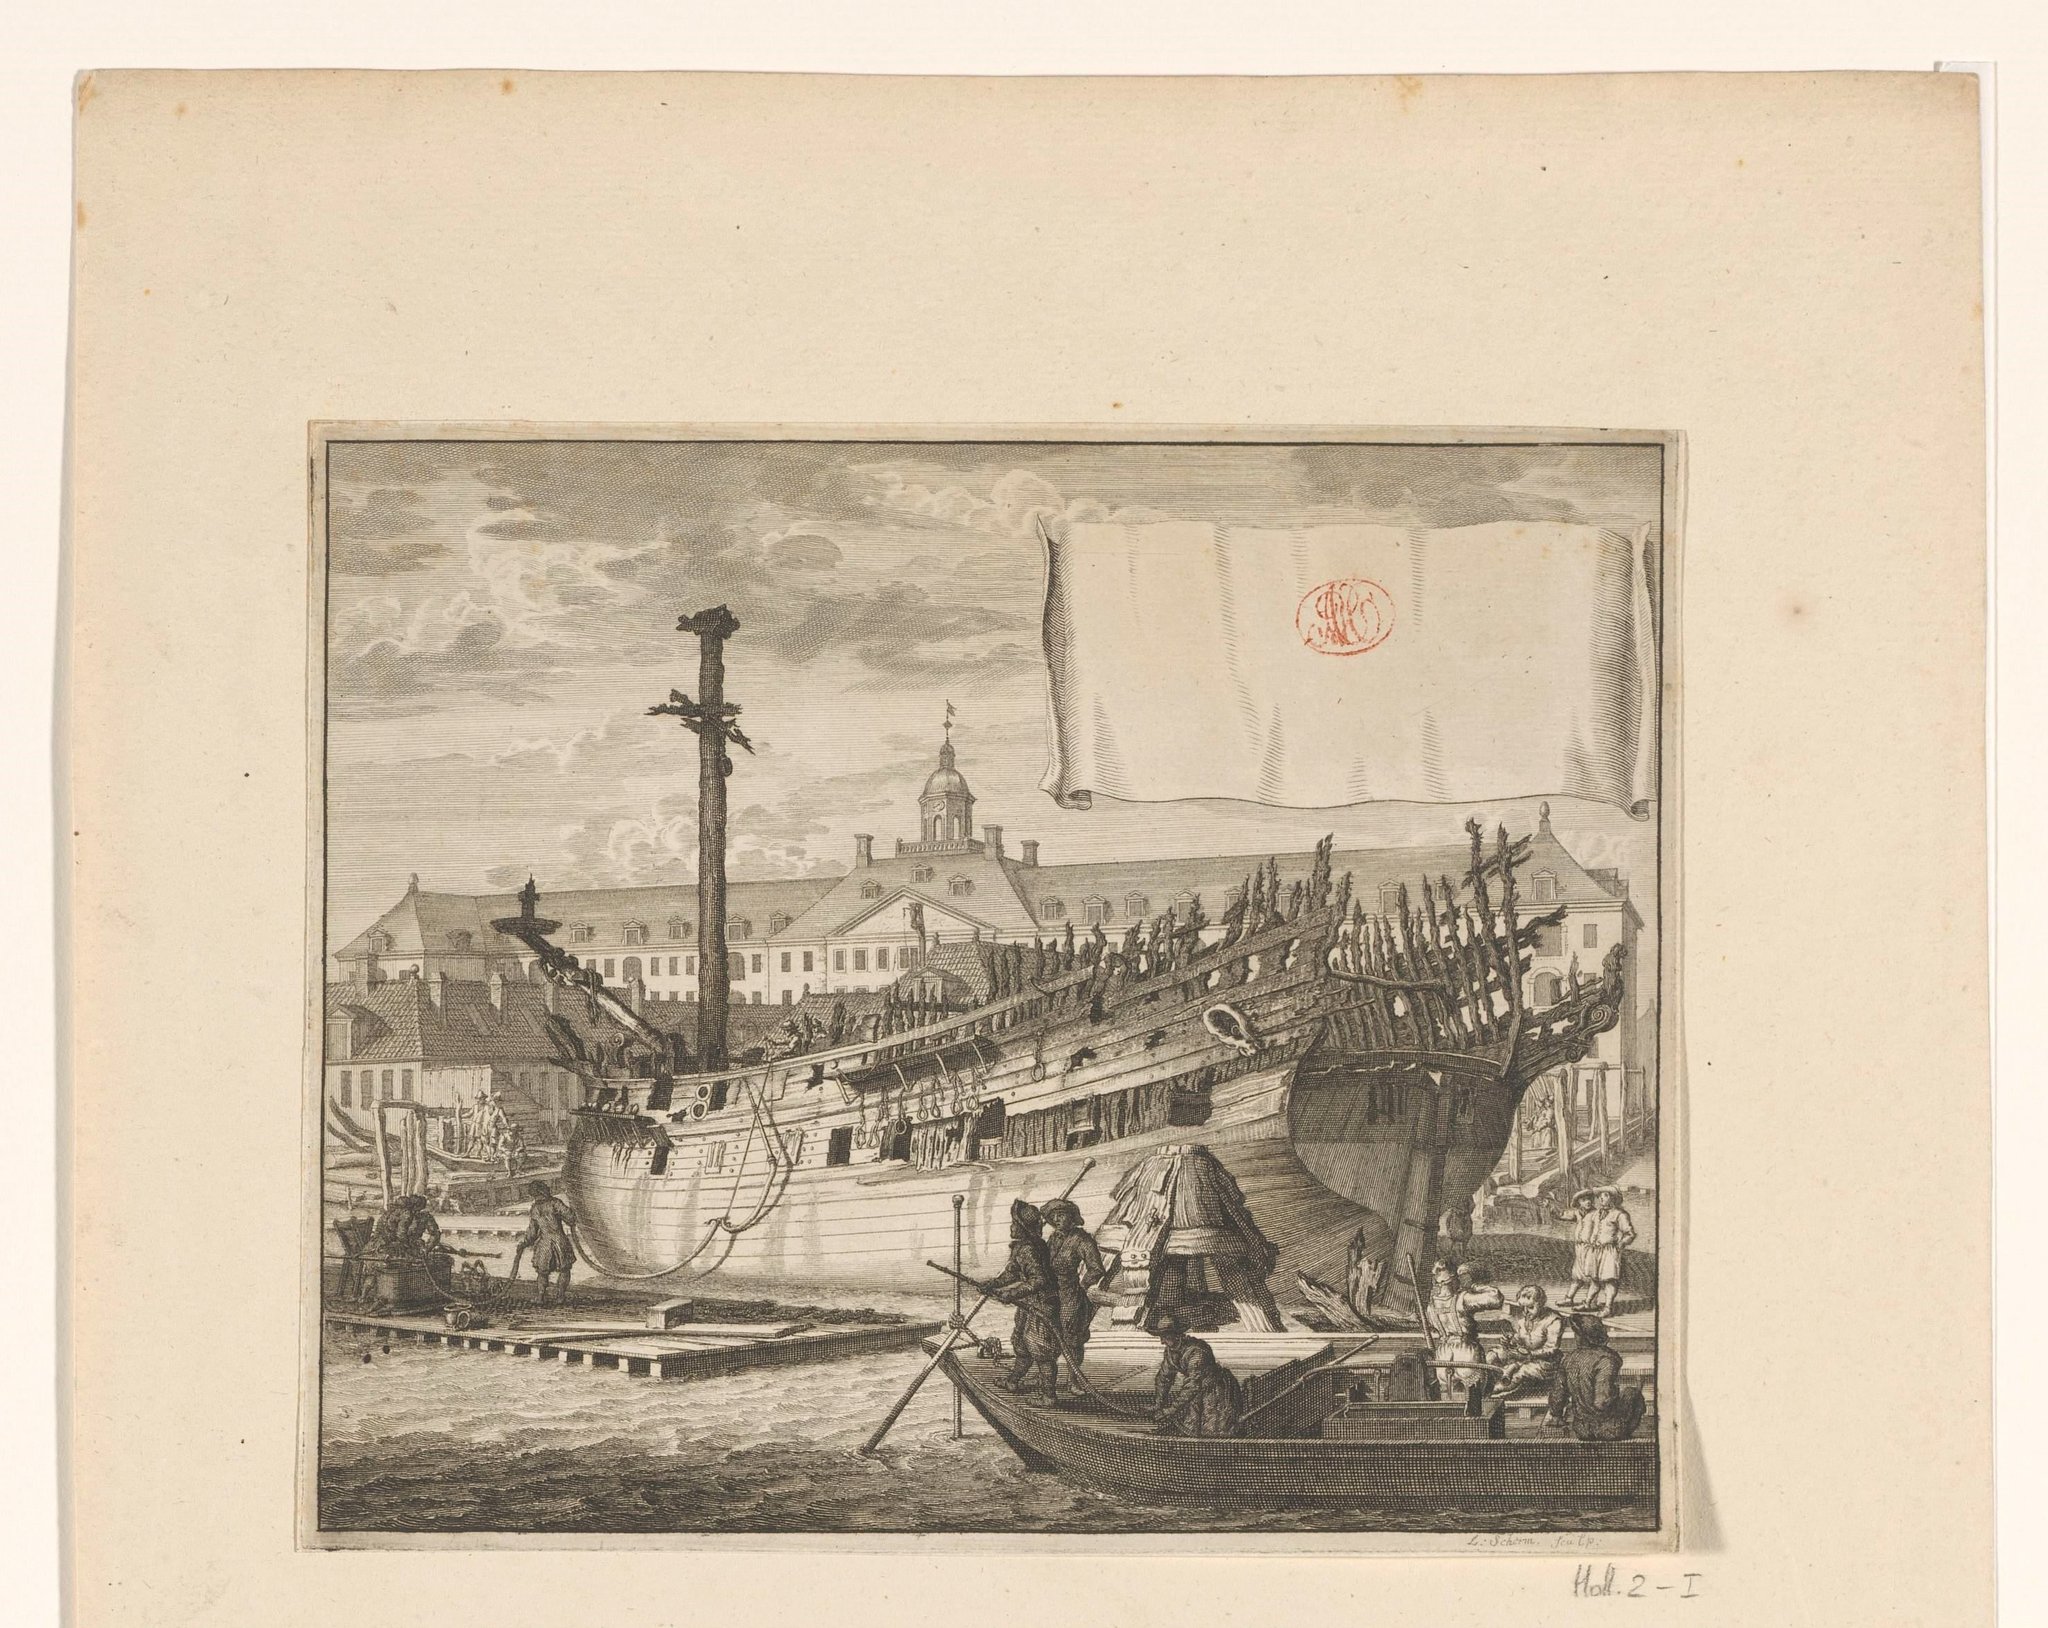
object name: print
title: Deels verbrand schip op de VOC-scheepswerf op Oostenburg, 1690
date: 1690-1702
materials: paper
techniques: engraving, etching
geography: amsterdam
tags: amsterdam, painter, draughtsman, jan van der heyden, building a ship, ship under construction, pump (fire-extinguishing equipment), fire-hose, shipyard, shipdock, fire-extinguishing equipment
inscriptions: collector's mark: Lugt 2228, collector's mark: Lugt 195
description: Latere staat van prent ook gebruikt in sommige exemplaren van: Heyden, Jan van der. Beschryving der nieuwlyks uitgevonden en geoctrojeerde slang-brand-spuiten en haare wyze van brand-blussen, tegenwoordig binnen Amsterdam in gebruik zijnde (…). 2e druk. Amsterdam: erfgenamen Jan van der Heyden, 1735. Verkleinde kopie naar de prent toegeschreven aan Jan van der Heyden (RP-P-OB-82.100, FMH 2301/19a).